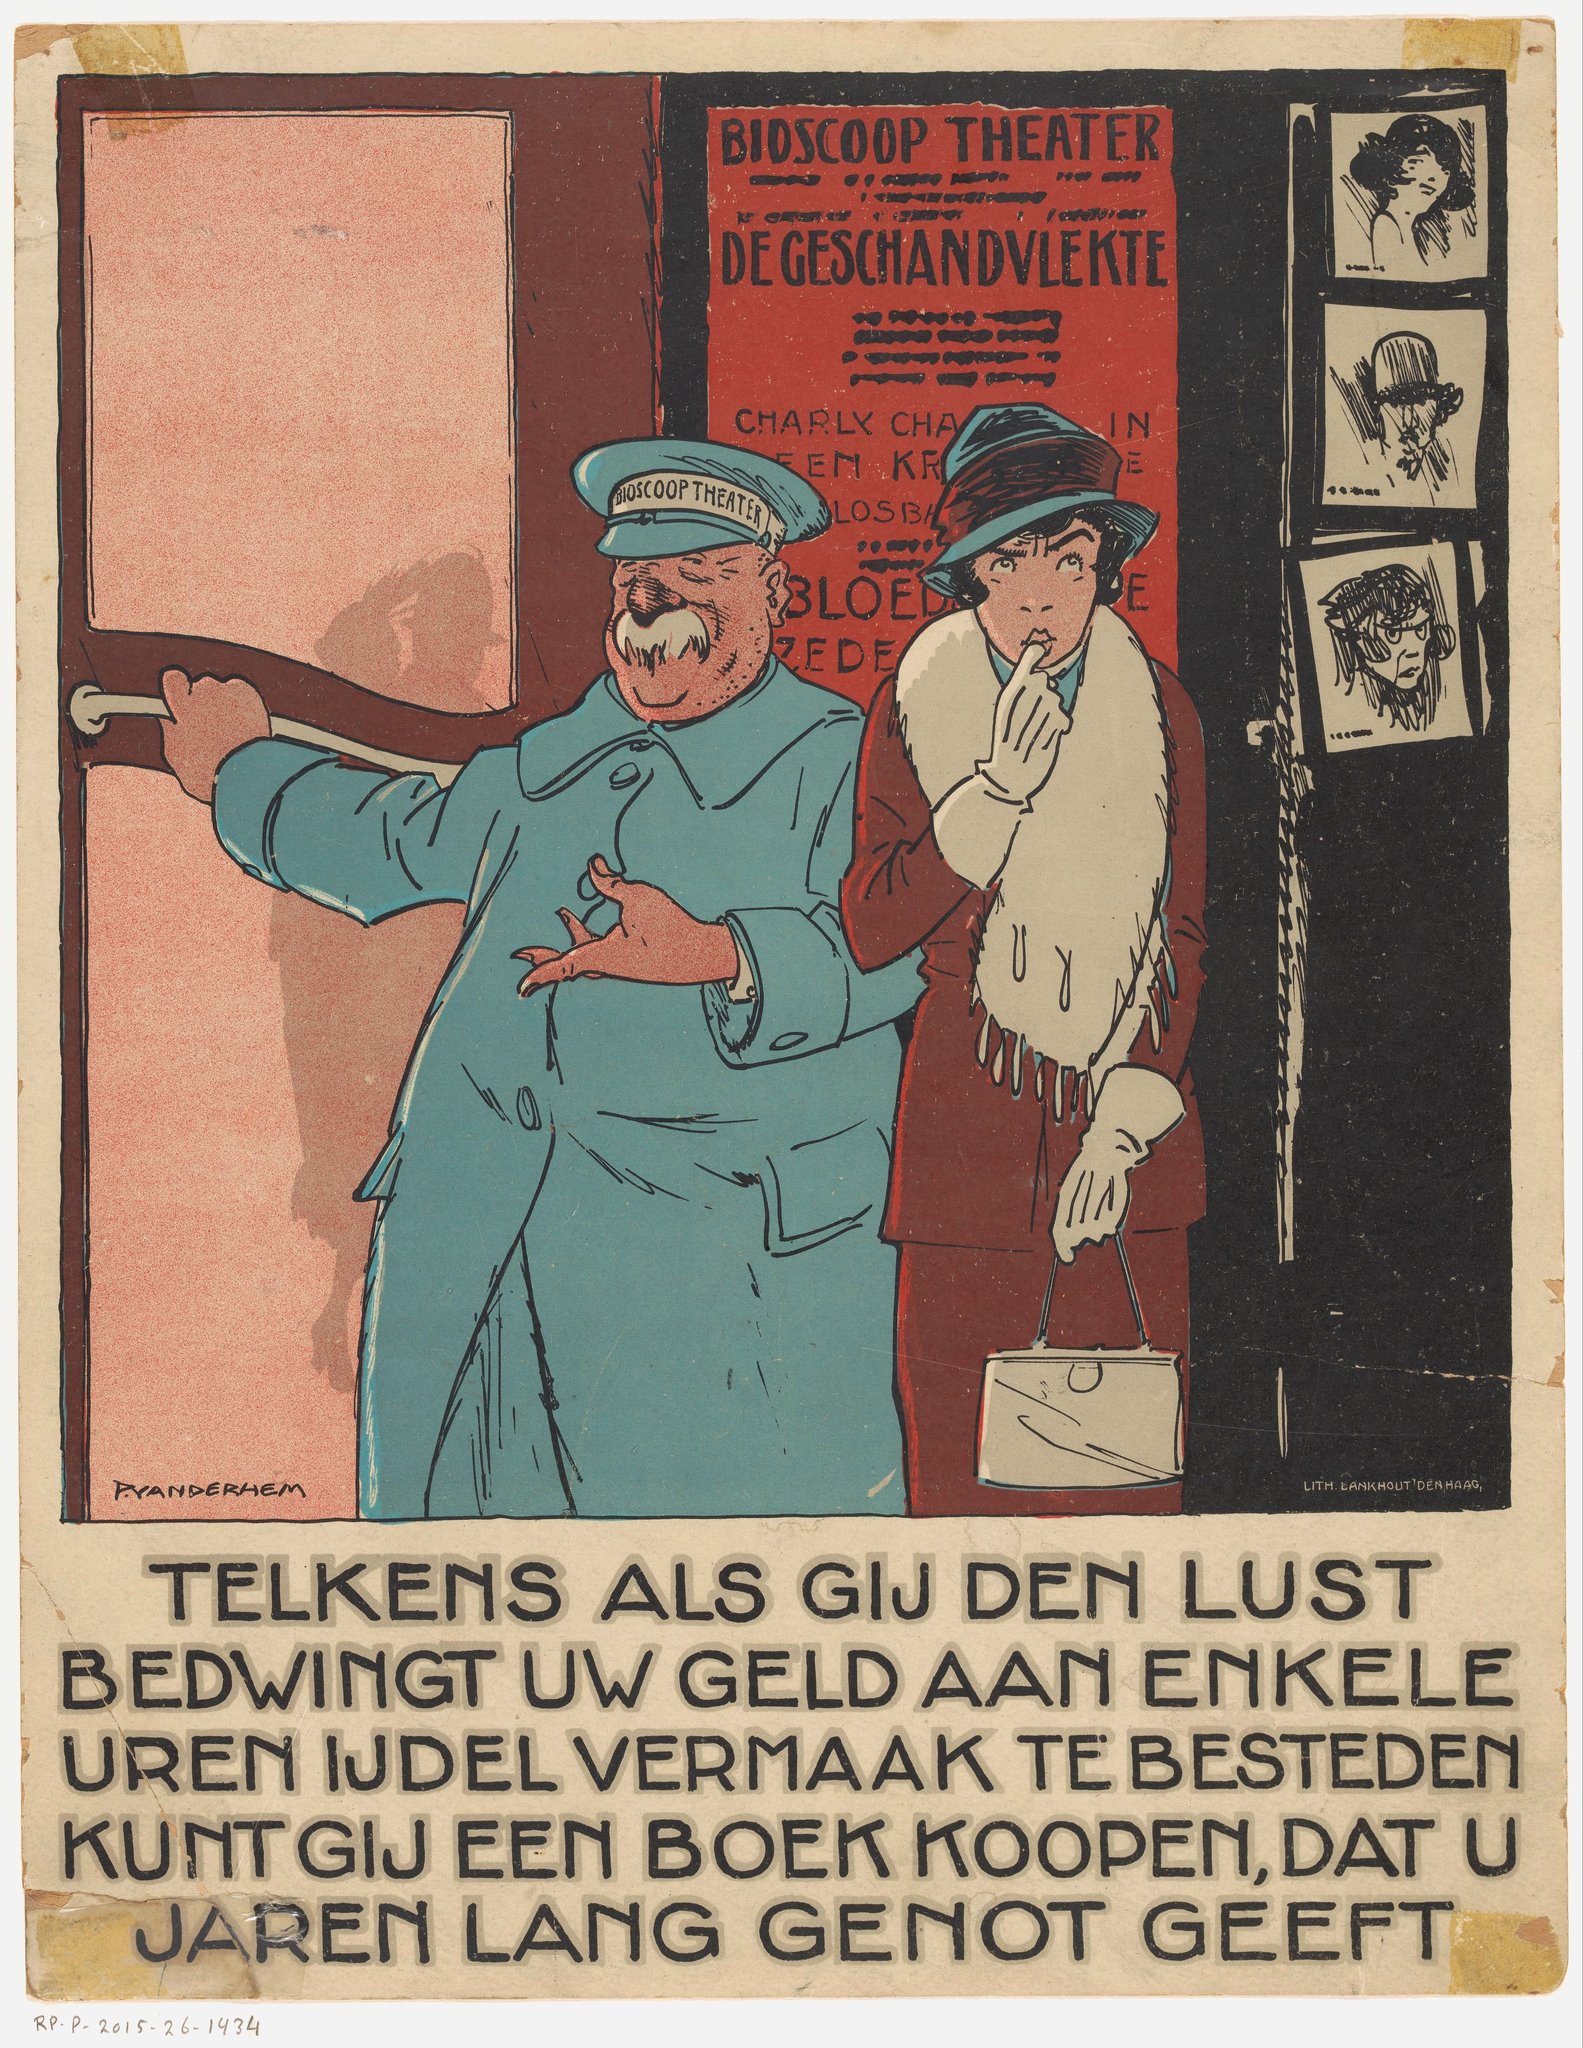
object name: reclamebiljet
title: Ingang van een bioscoop met een vrouw en een portier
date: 1921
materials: cardboard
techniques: chromolithography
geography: amsterdam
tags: house-guard, doorkeeper, janitor, cinema, movie-house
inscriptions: collector's mark: Lugt 2228, collector's mark: Lugt 4779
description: De portier, een man in een lange jas en een pet met 'Bioscoop Theater', houdt met zijn rechterarm de deur open; met zijn linkerarm maakt hij een uitnodigend gebaar. De vrouw twijfelt of ze haar geld uit zal geven aan een bioscoopbezoek. In de achtergrond een advertentie voor de film 'De Geschandvlekte'. Met vijfregelig onderschrift in het Nederlands.